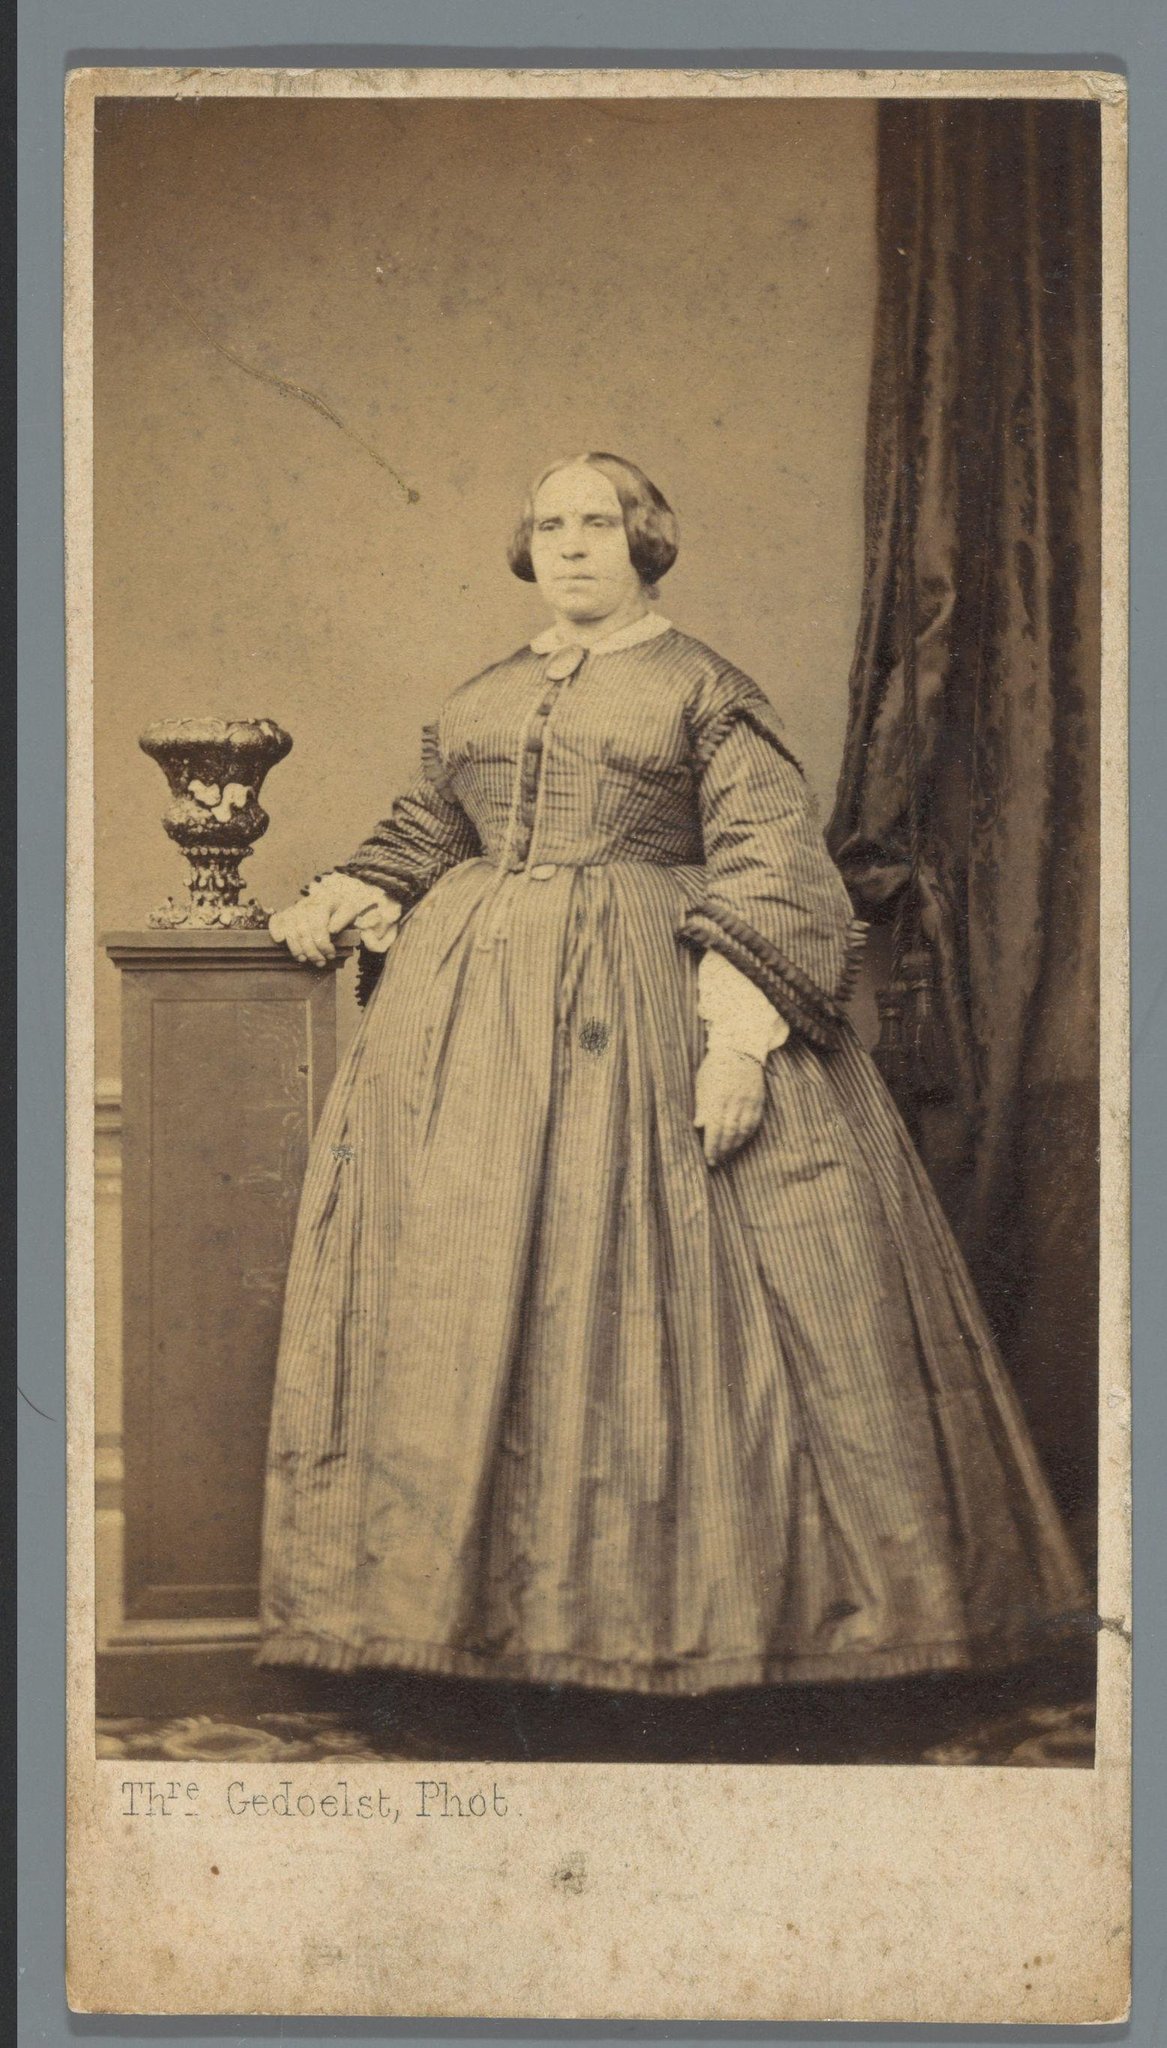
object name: carte de visite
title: Portret van een onbekende vrouw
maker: théodore gedoelst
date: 1863-1866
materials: cardboard, paper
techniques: albumen print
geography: leuven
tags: adult woman, anonymous historical person portrayed, louvain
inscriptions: inscription: ‘Thre Gedoelst, Phot.’, inscription: ‘Atelier de photographie/ Thre Gedoelst,/ Rue de Malines, 40./ Louvain’